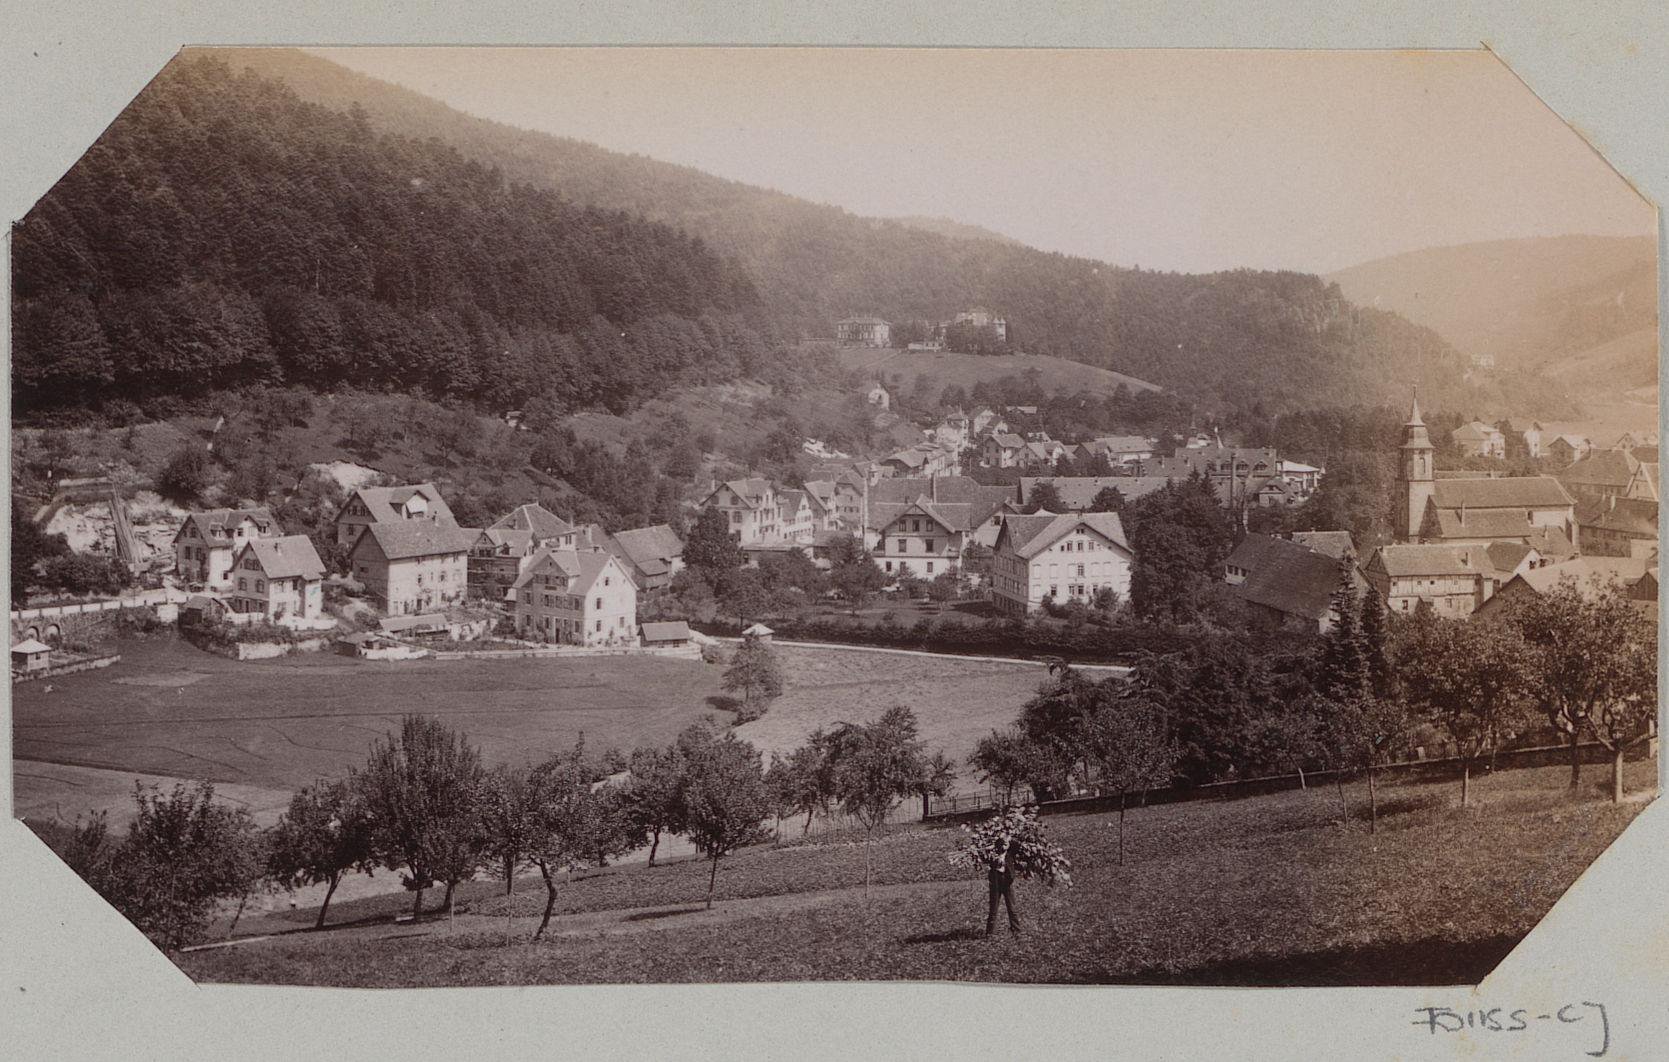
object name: photograph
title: Gezicht op Bad Herrenalb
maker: albert schmidt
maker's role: publisher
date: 1899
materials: photographic support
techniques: albumen print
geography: bad herrenalb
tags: city-view in general; 'veduta'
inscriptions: annotation: ‘Herrenalb vom Friedhof’, inscription: ‘A. Schmidt/ Pforzheim/ 1899’